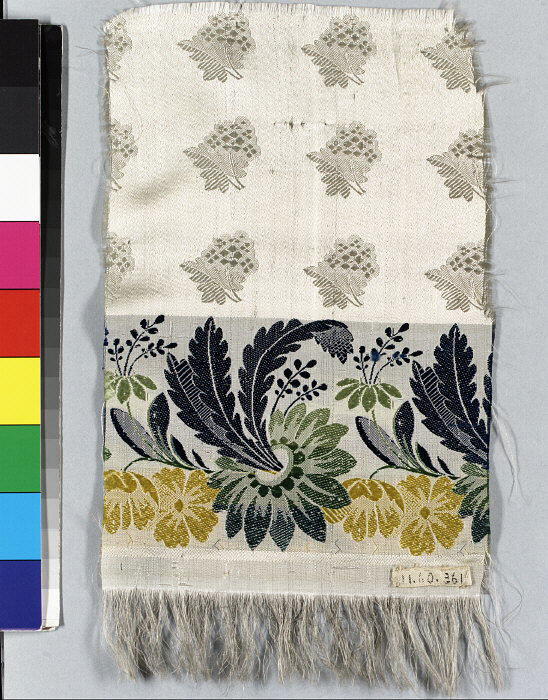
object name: fragment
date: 1801-1900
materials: silk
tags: flowers,leaves